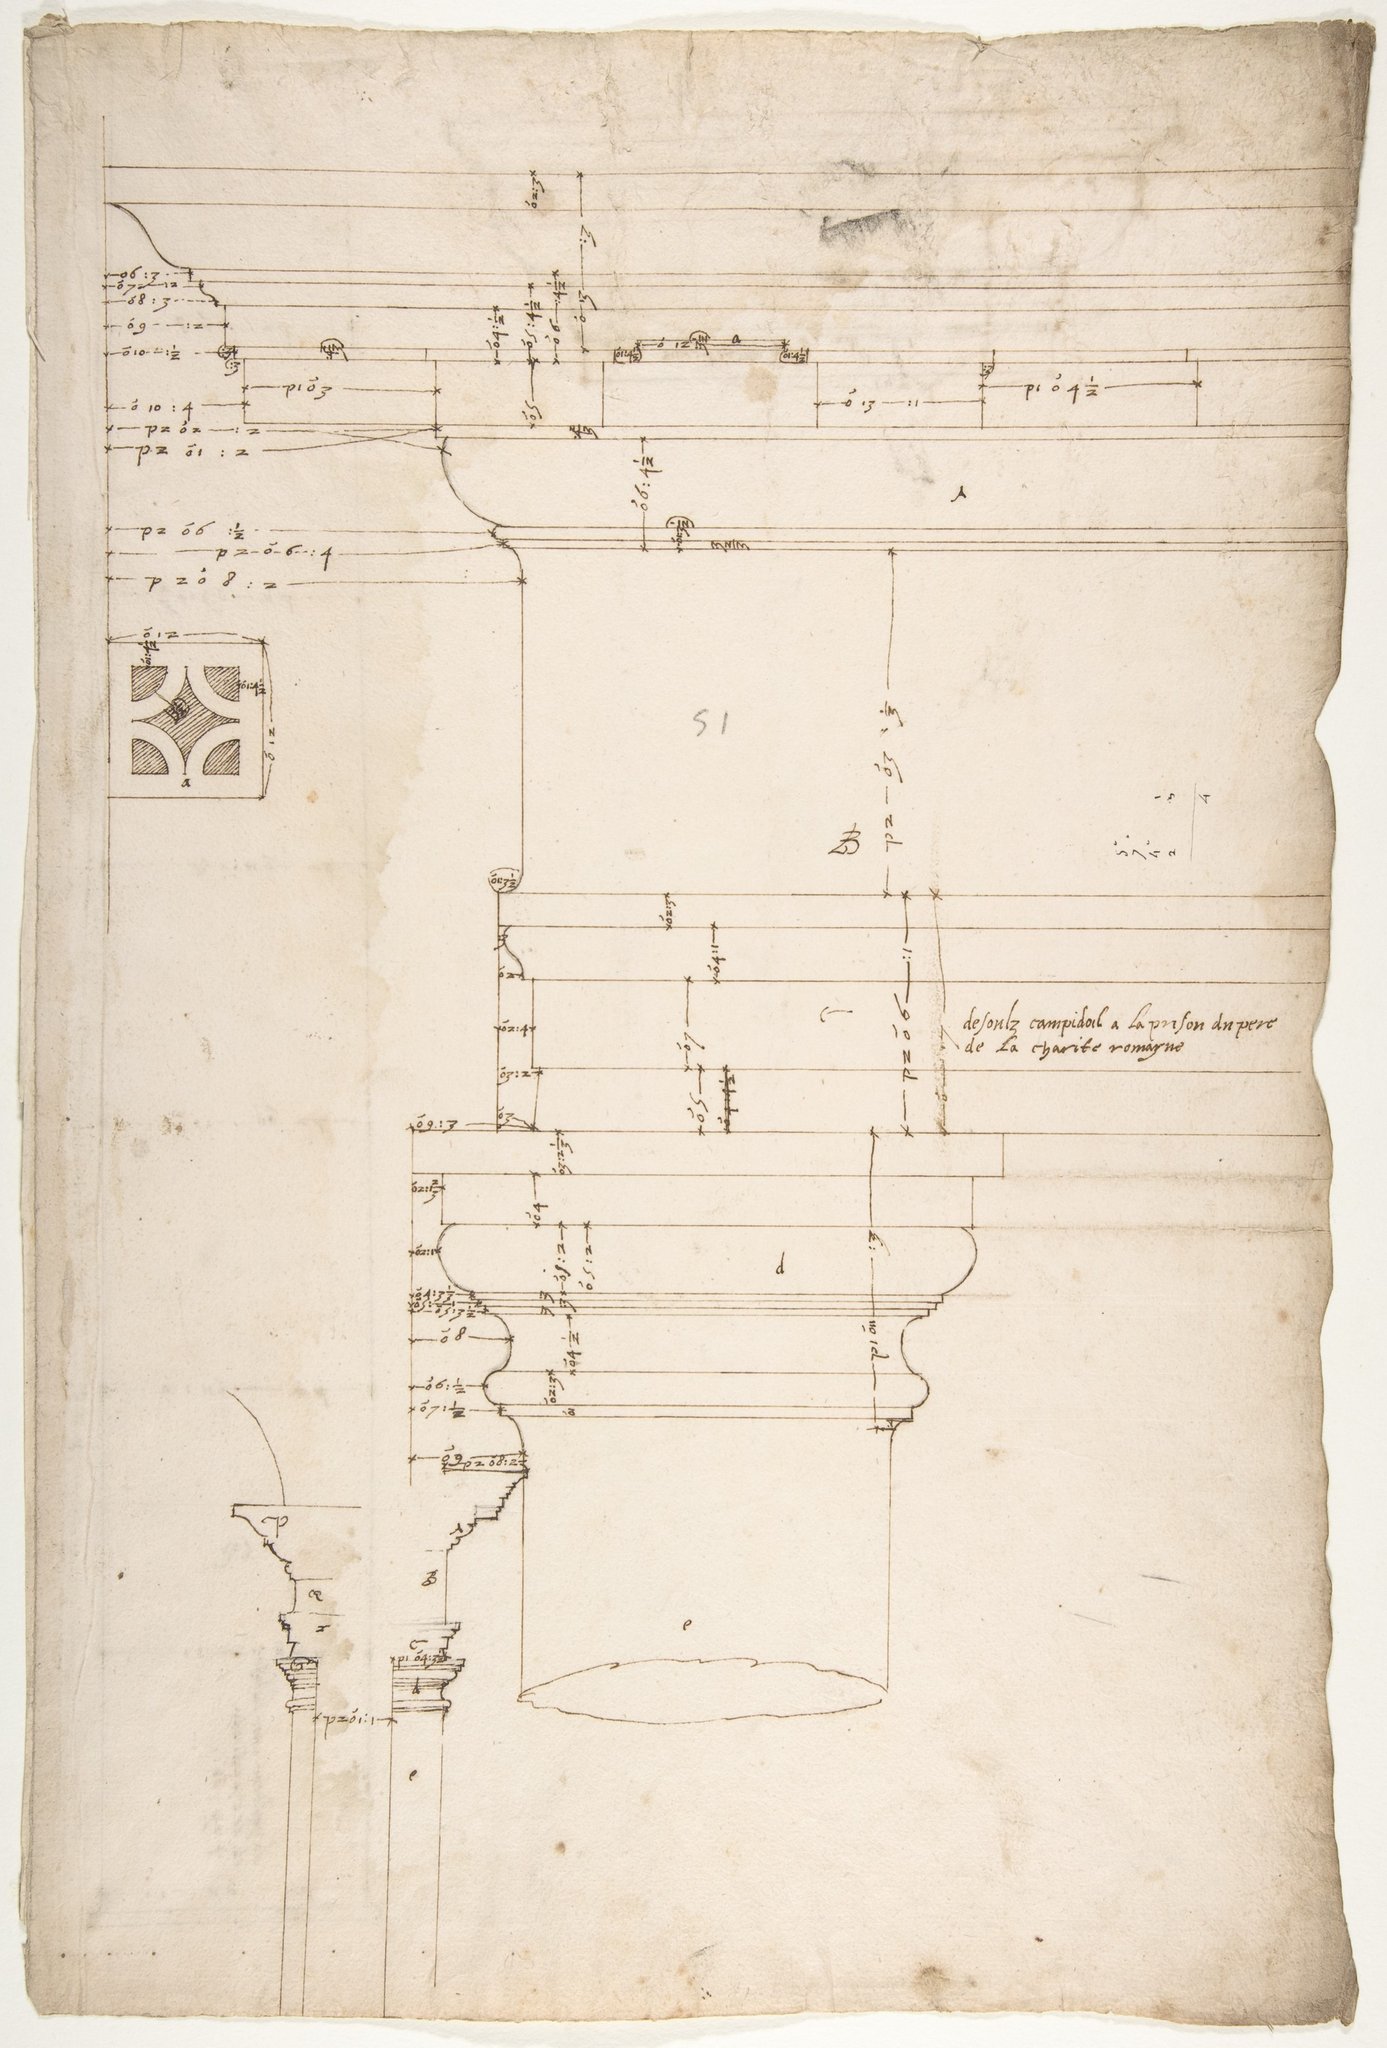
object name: collection ornament architecture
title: Portico at the Porta Carmentalis, Tuscan capital and entablature, elevation; pier, section, detail (recto) S. Prassede, Quadriportico, Doric capital, elevation; Palazzo Massimo alle Colonne, column shaft, profile (verso)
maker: anonymous, french, 16th century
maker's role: draftsman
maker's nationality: french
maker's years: 1500-1600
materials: chalk, ink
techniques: incising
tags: architecture